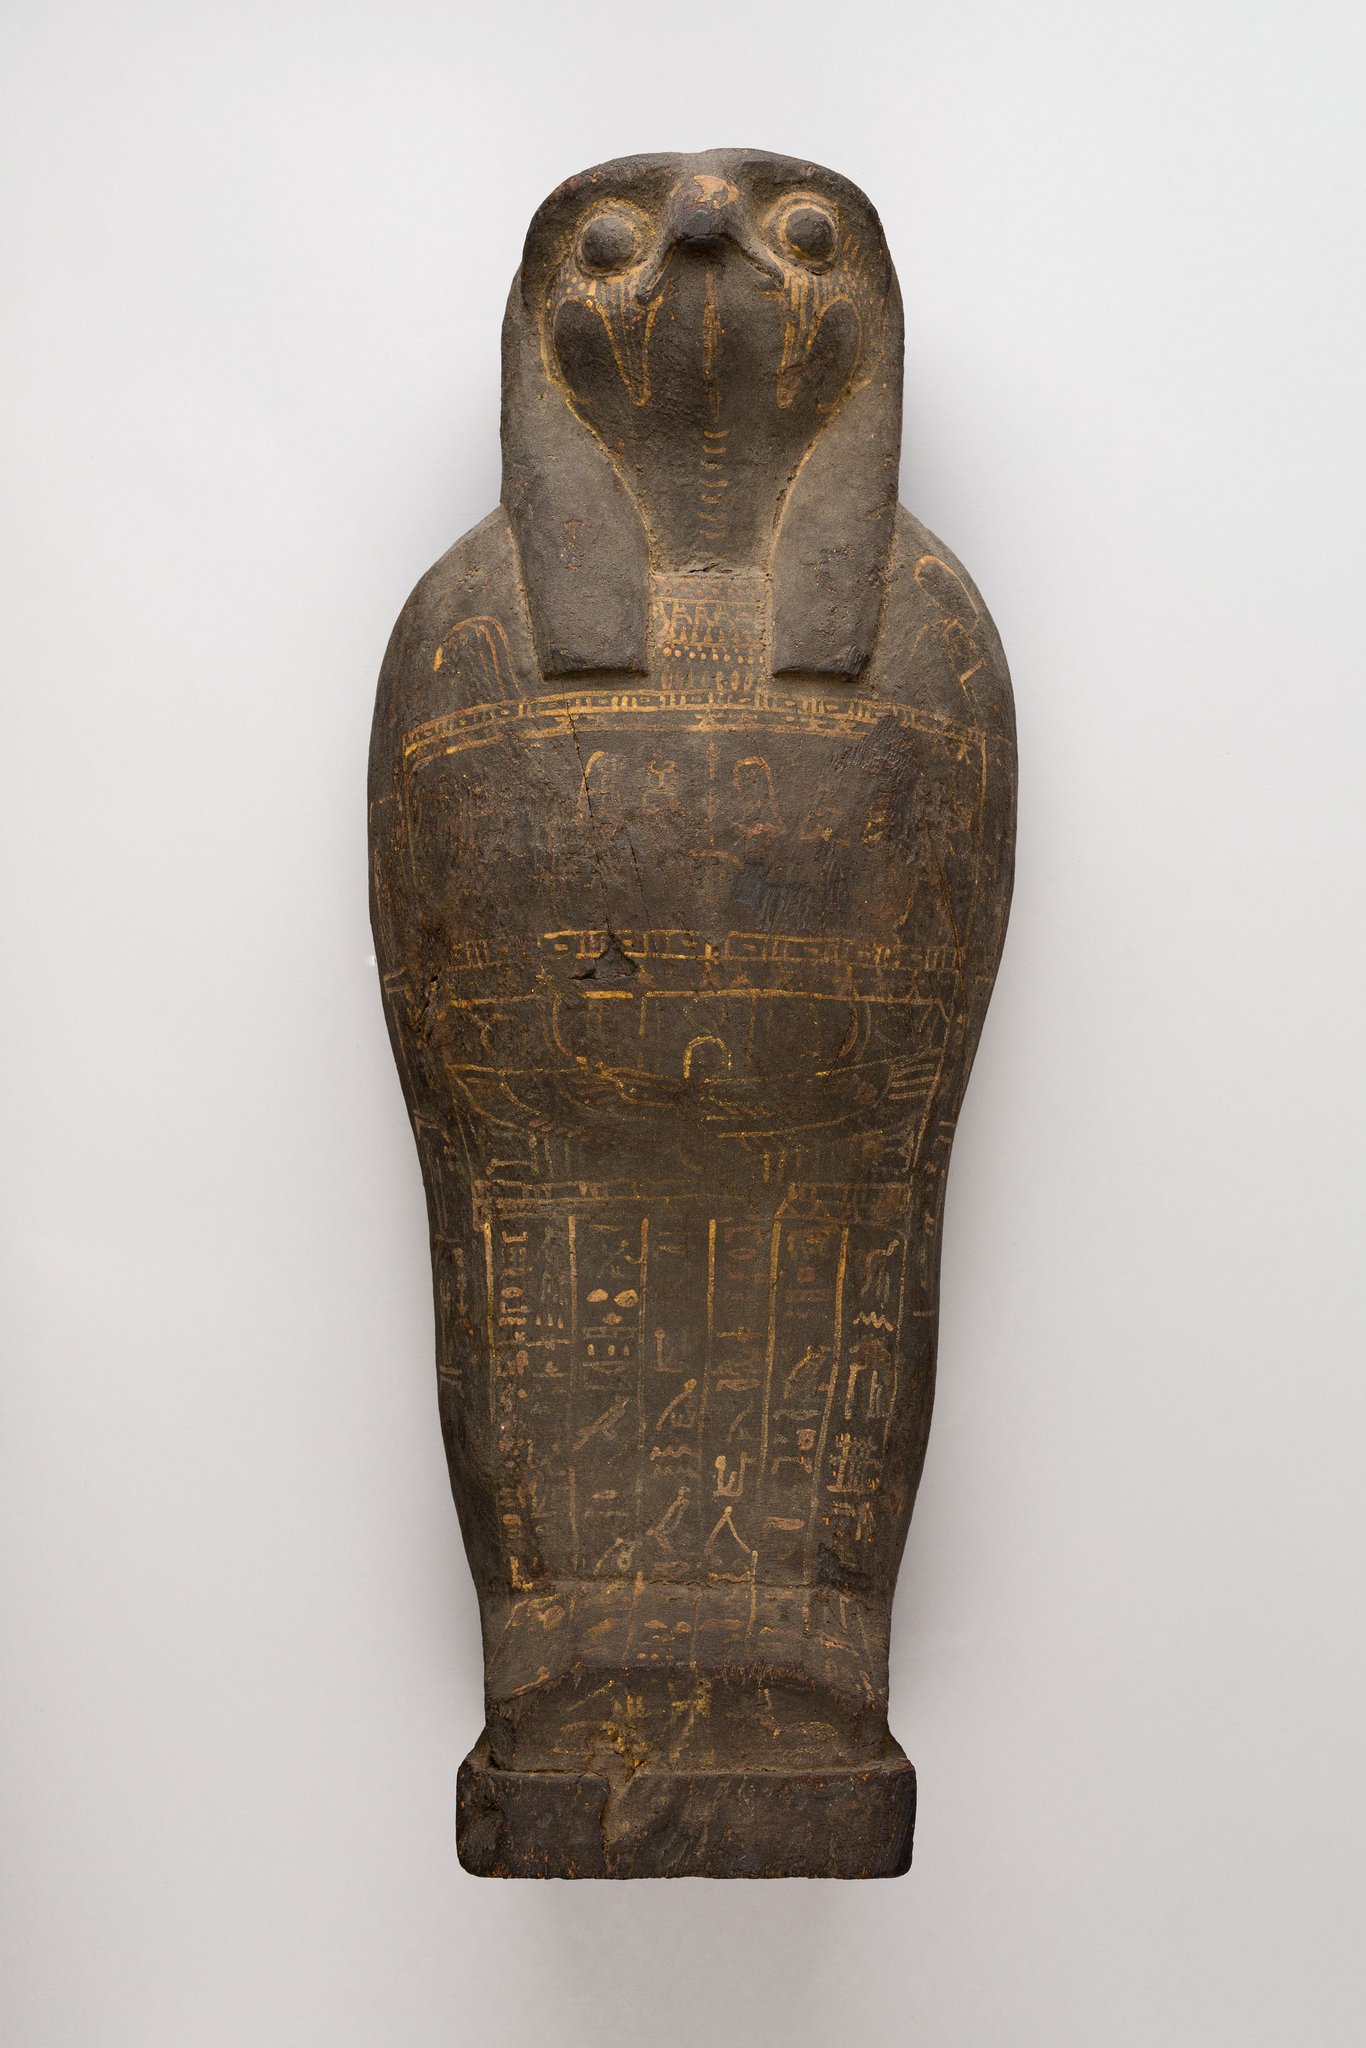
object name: coffin, corn mummy, mask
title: Coffin and corn mummy with Osiris mask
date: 400-200 BCE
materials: clay, linen, paint, wax, wood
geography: egypt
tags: falcons,hieroglyphs,coffins